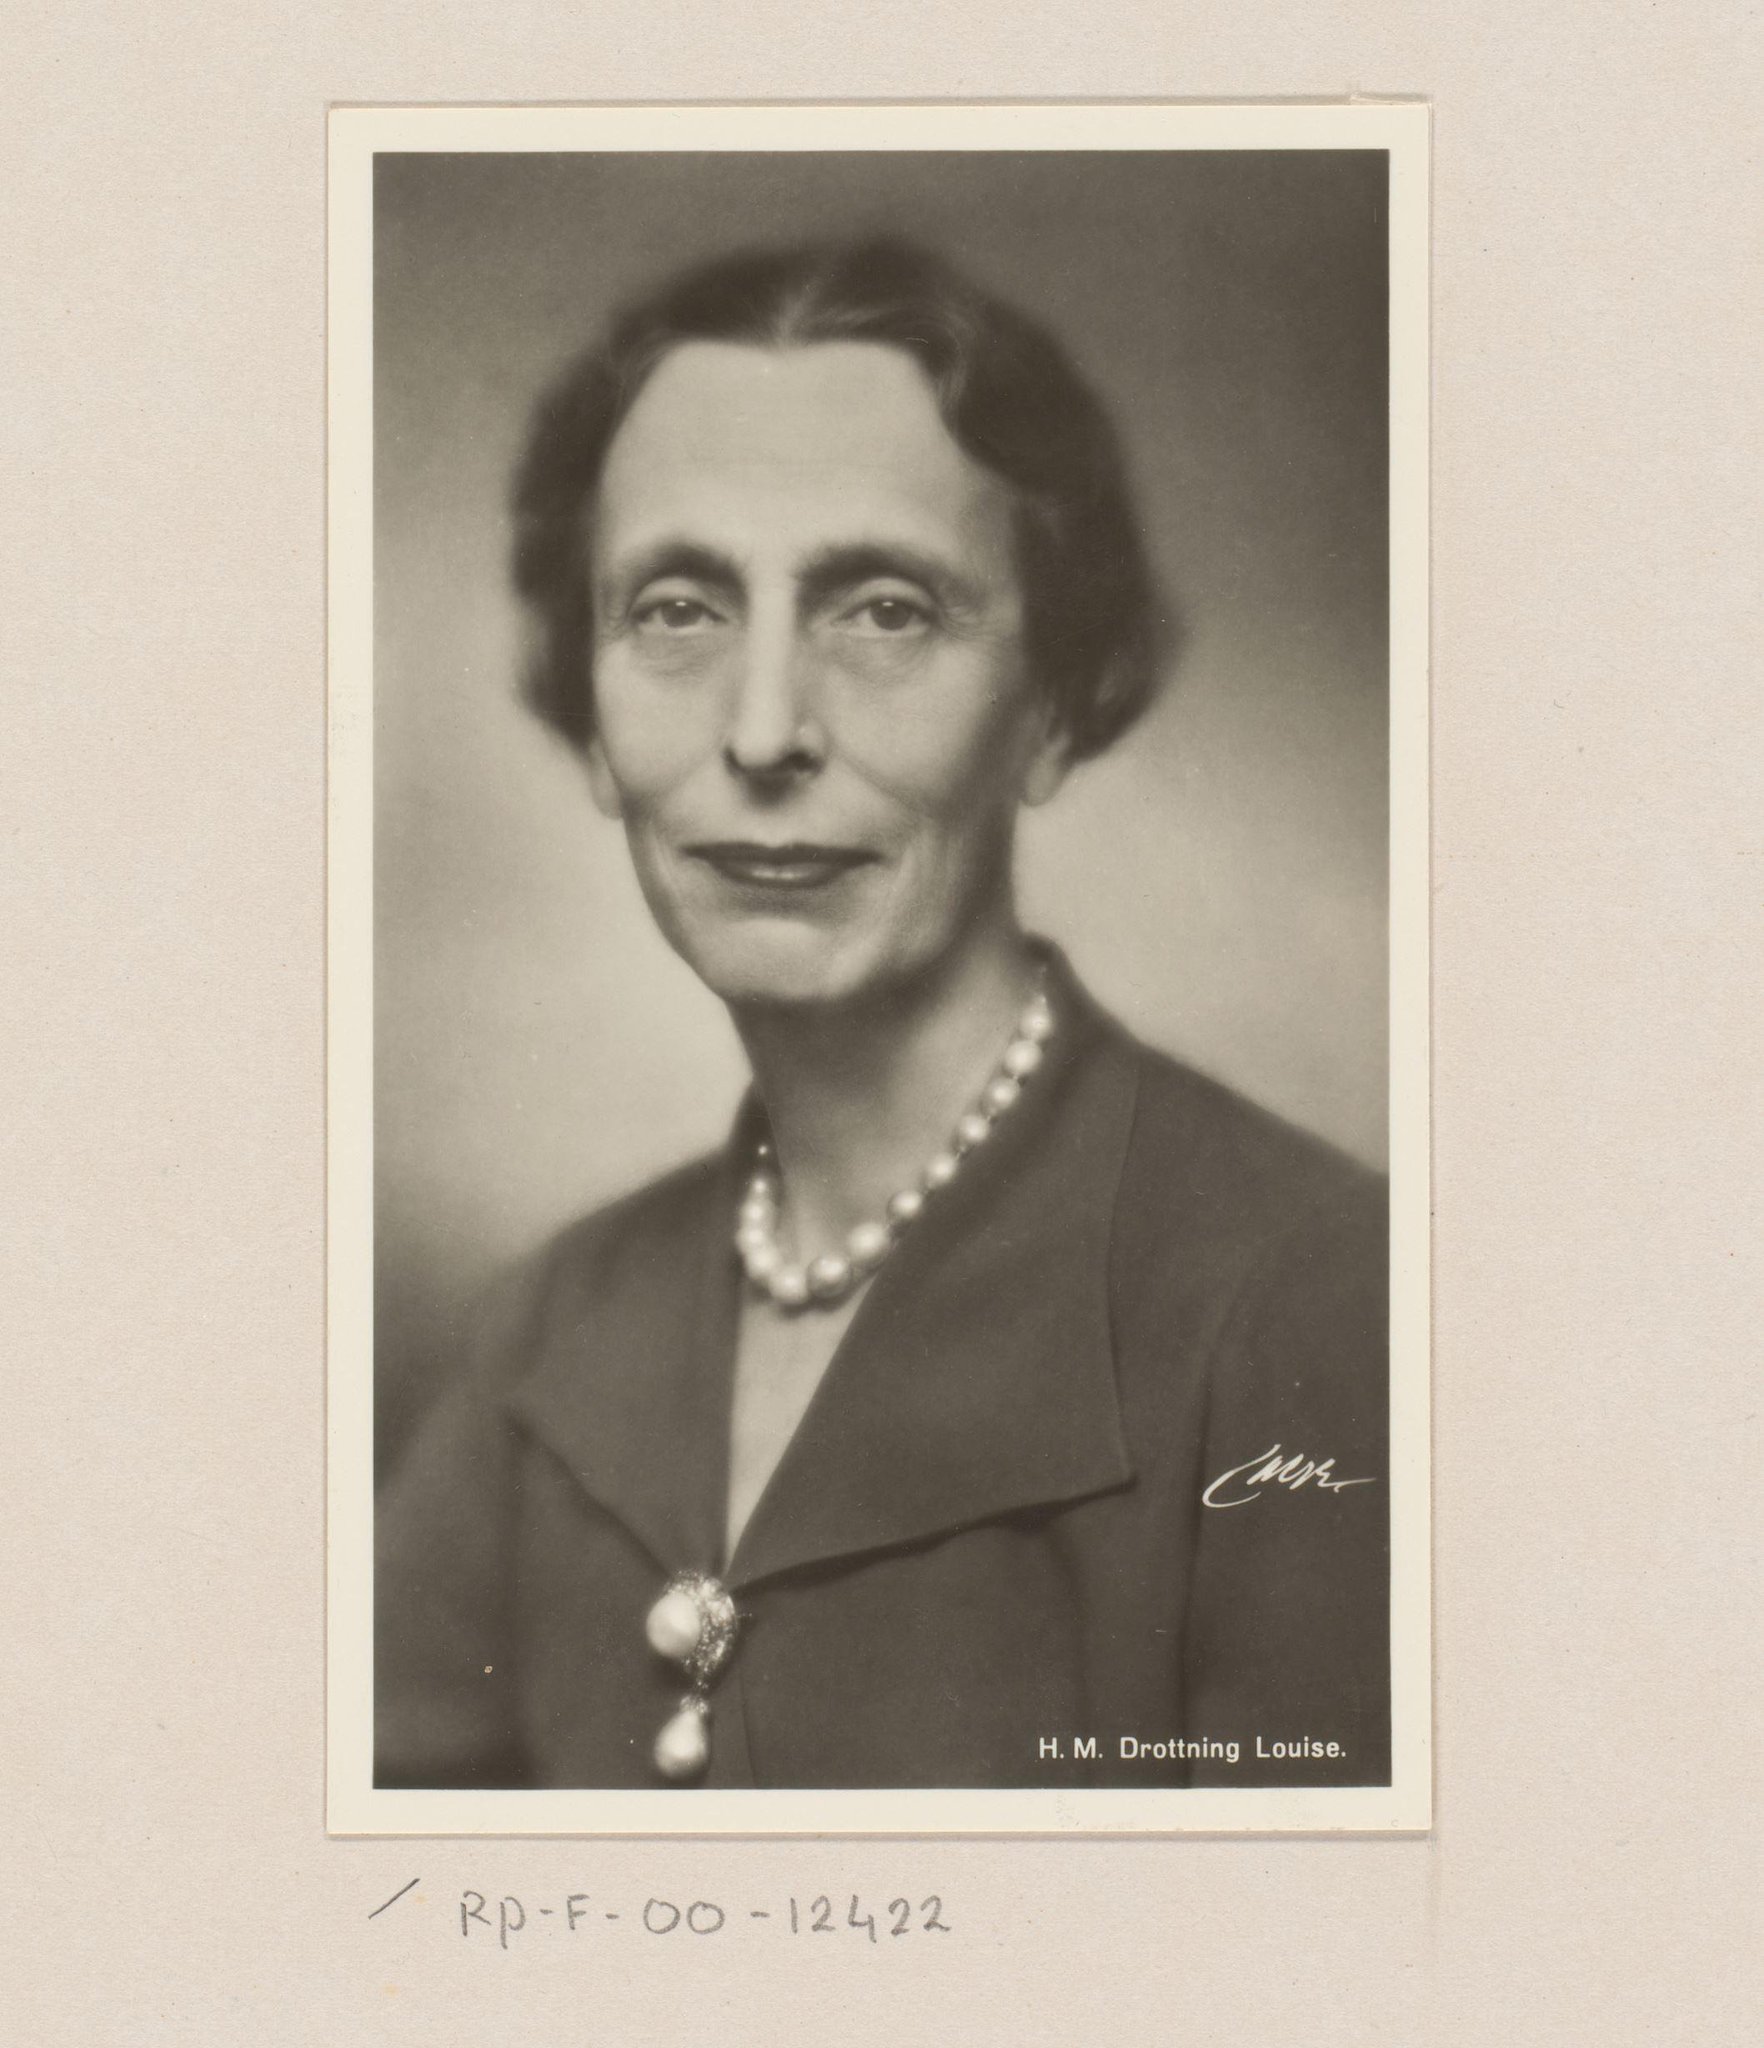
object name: photograph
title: H.M. Drotting Louise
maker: Anonymous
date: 1950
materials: paper, cardboard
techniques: gelatin silver print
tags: historical persons - bb - woman, queen